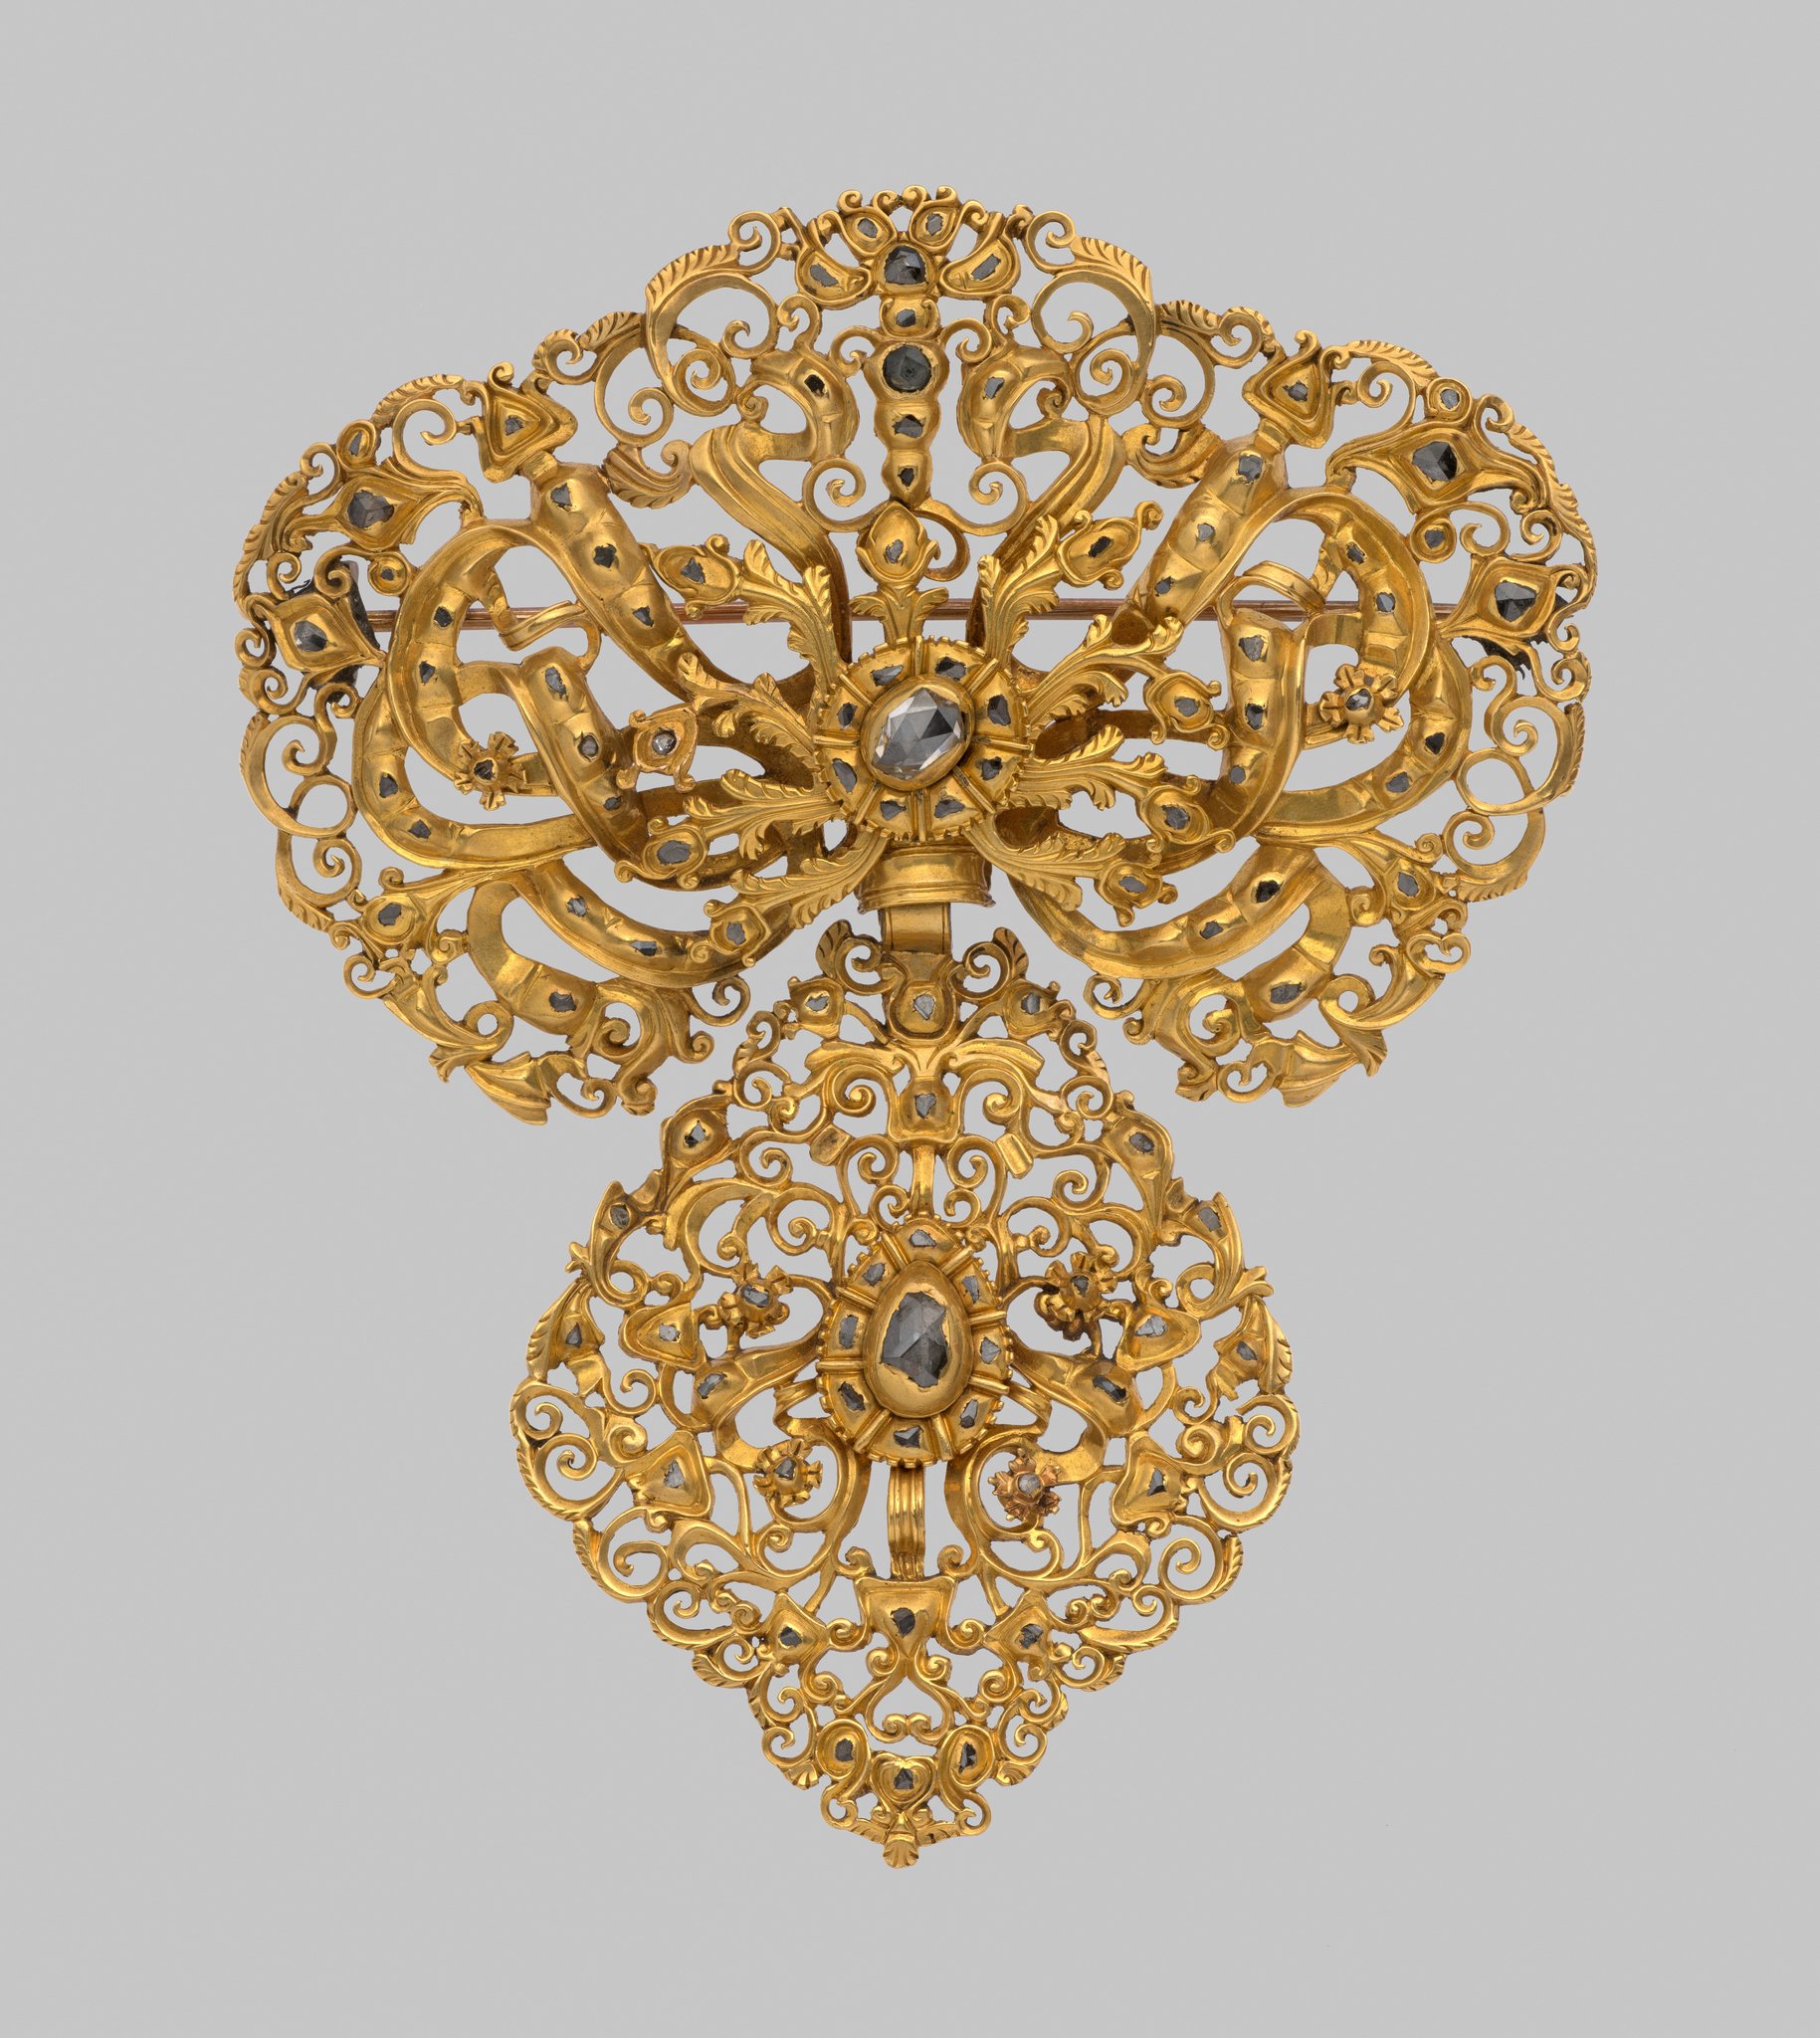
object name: corsage ornament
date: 1701-1800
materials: diamond, gold